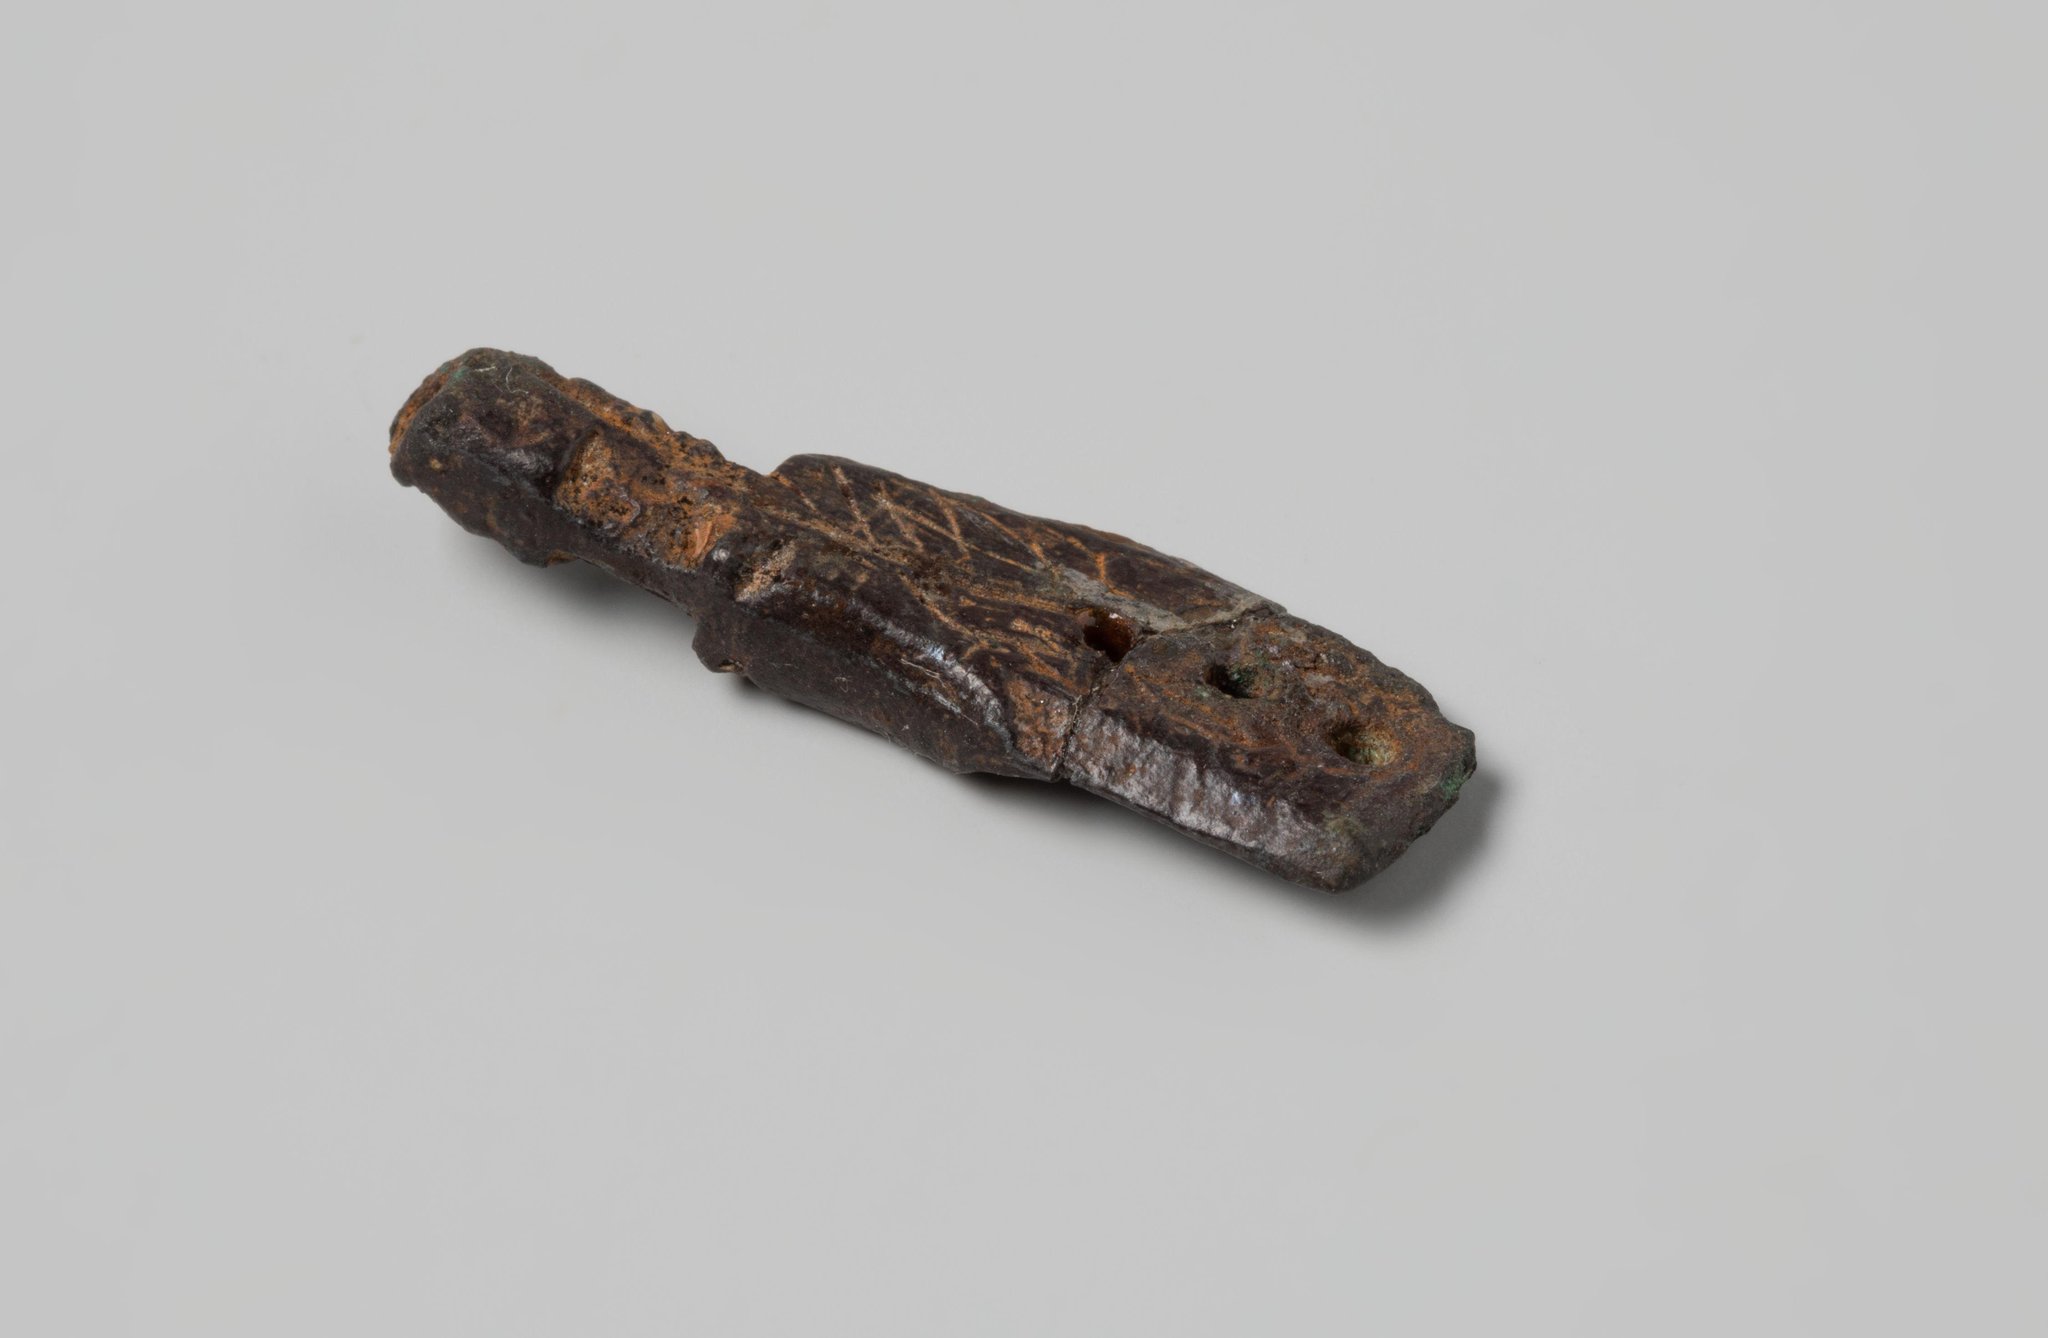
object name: pin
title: Speld uit het wrak van de Oost-Indiëvaarder Hollandia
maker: Anonymous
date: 1700-1743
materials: copper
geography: netherlands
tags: verenigde oostindische compagnie, hollandia (schip), annet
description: Tools and instruments, sewing and sailmaking, pin; fragm of shaft with blade-mount, 3 rivet-holes, id. NG 1980-27H3265.